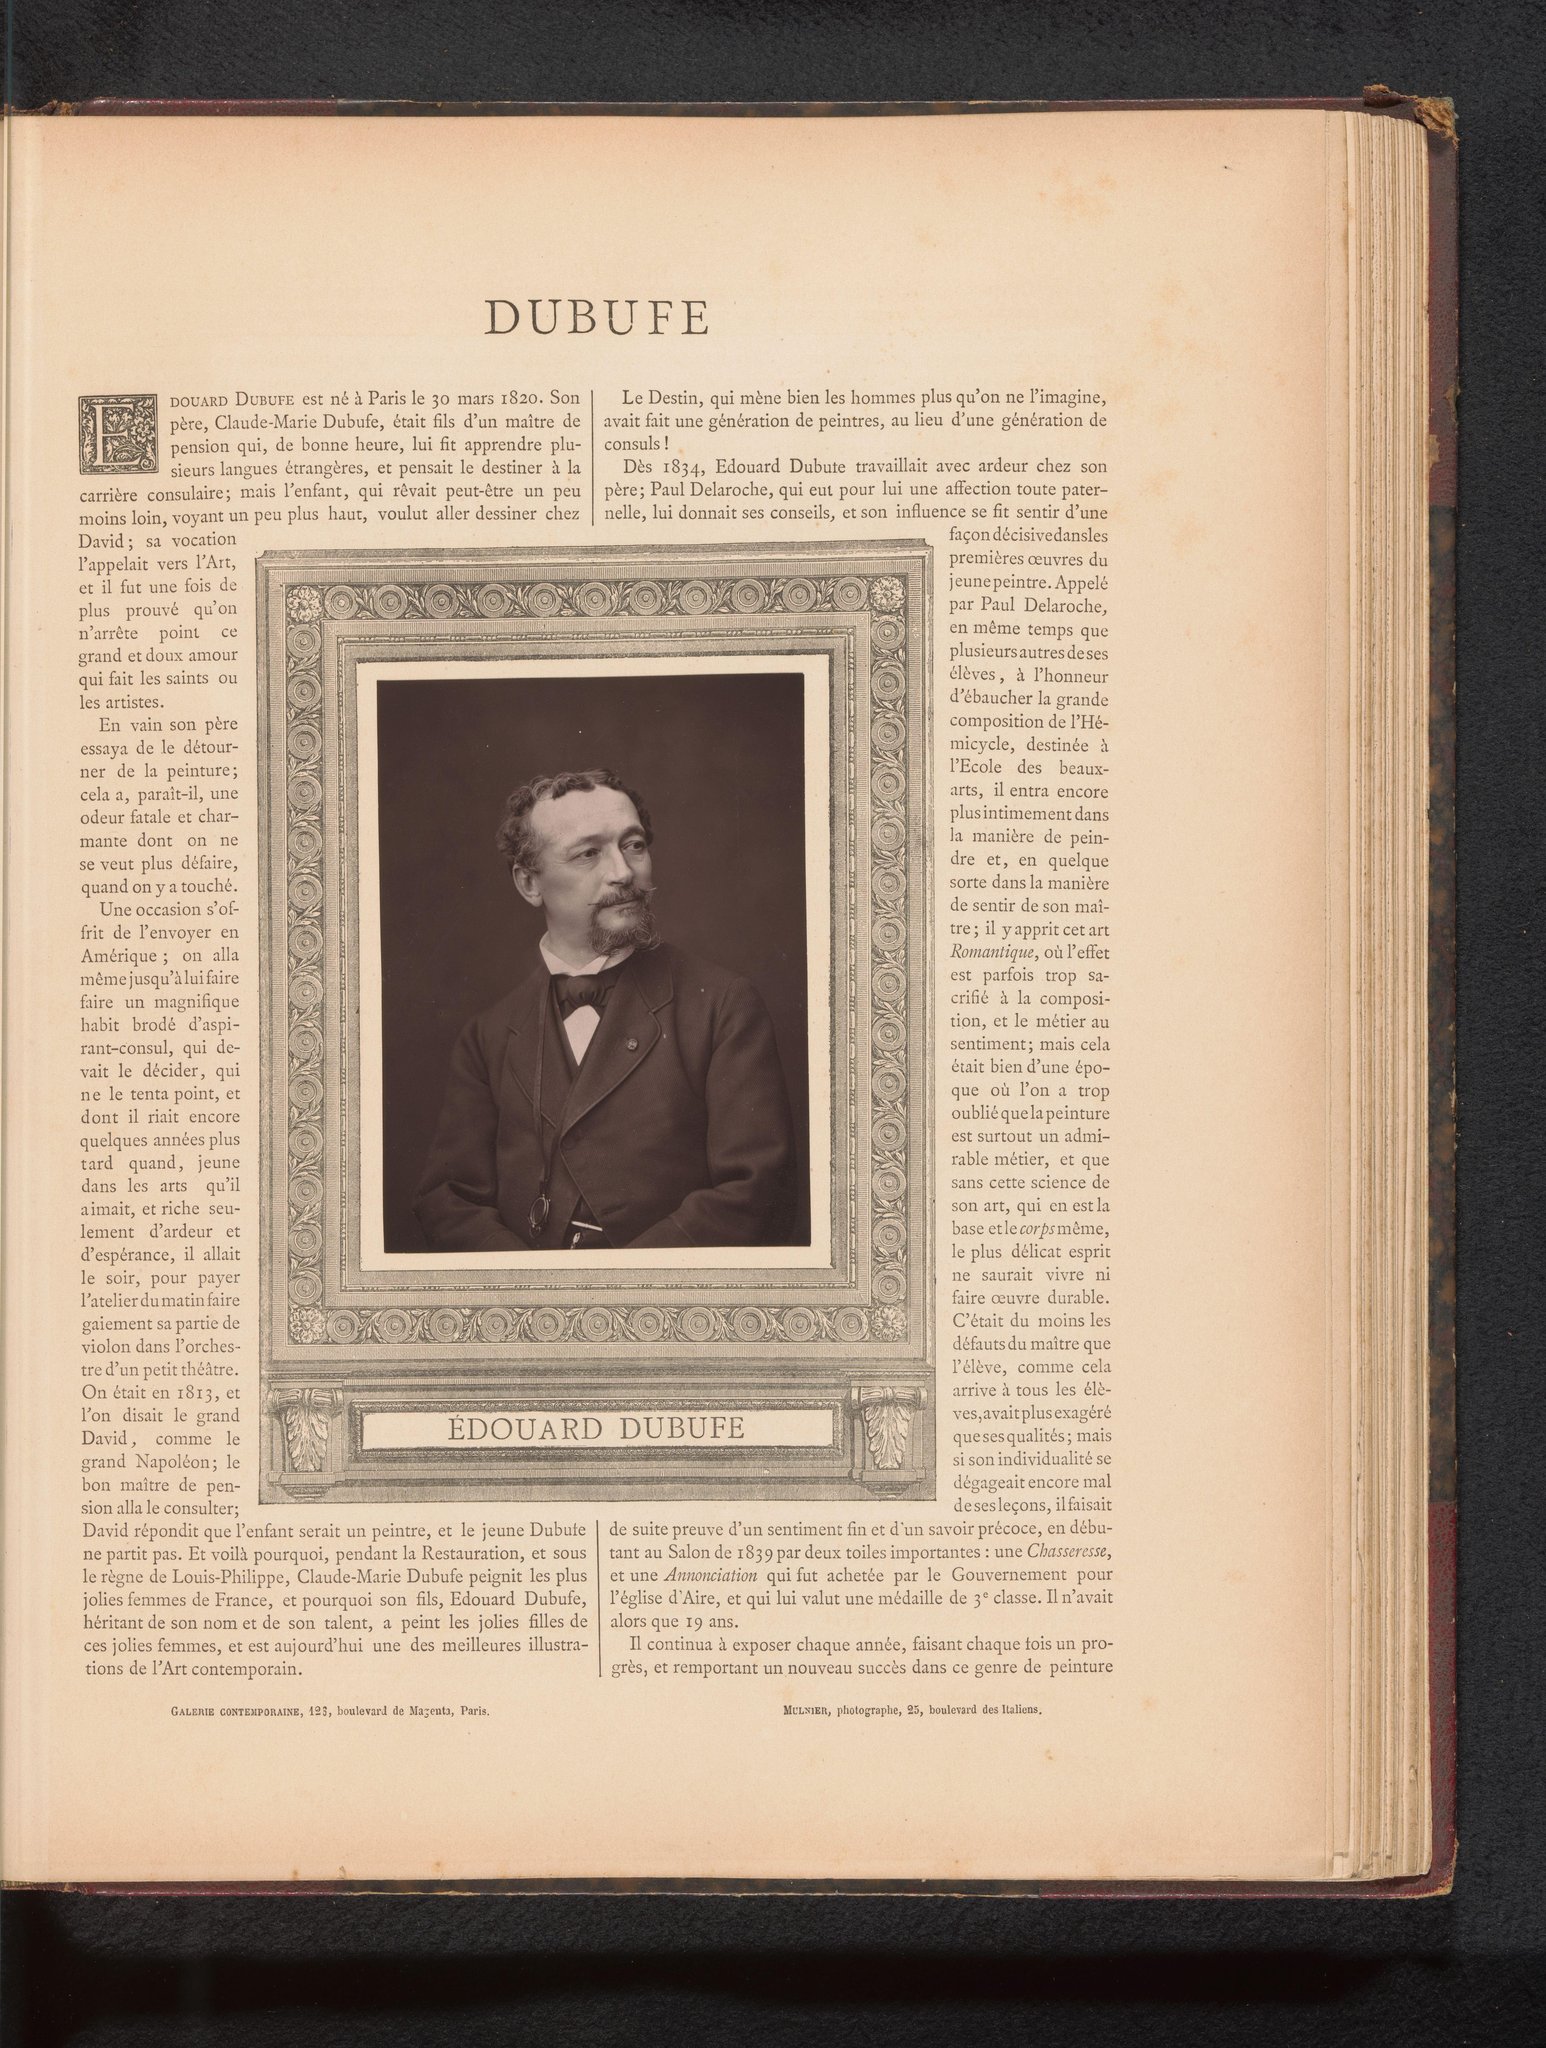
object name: photomechanical print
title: Edouard Dubufe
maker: ferdinand mulnier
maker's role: painter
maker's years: 1817-1891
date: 1871-1876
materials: paper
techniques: woodburytype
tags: painter, edouard dubufe, adult man, historical persons